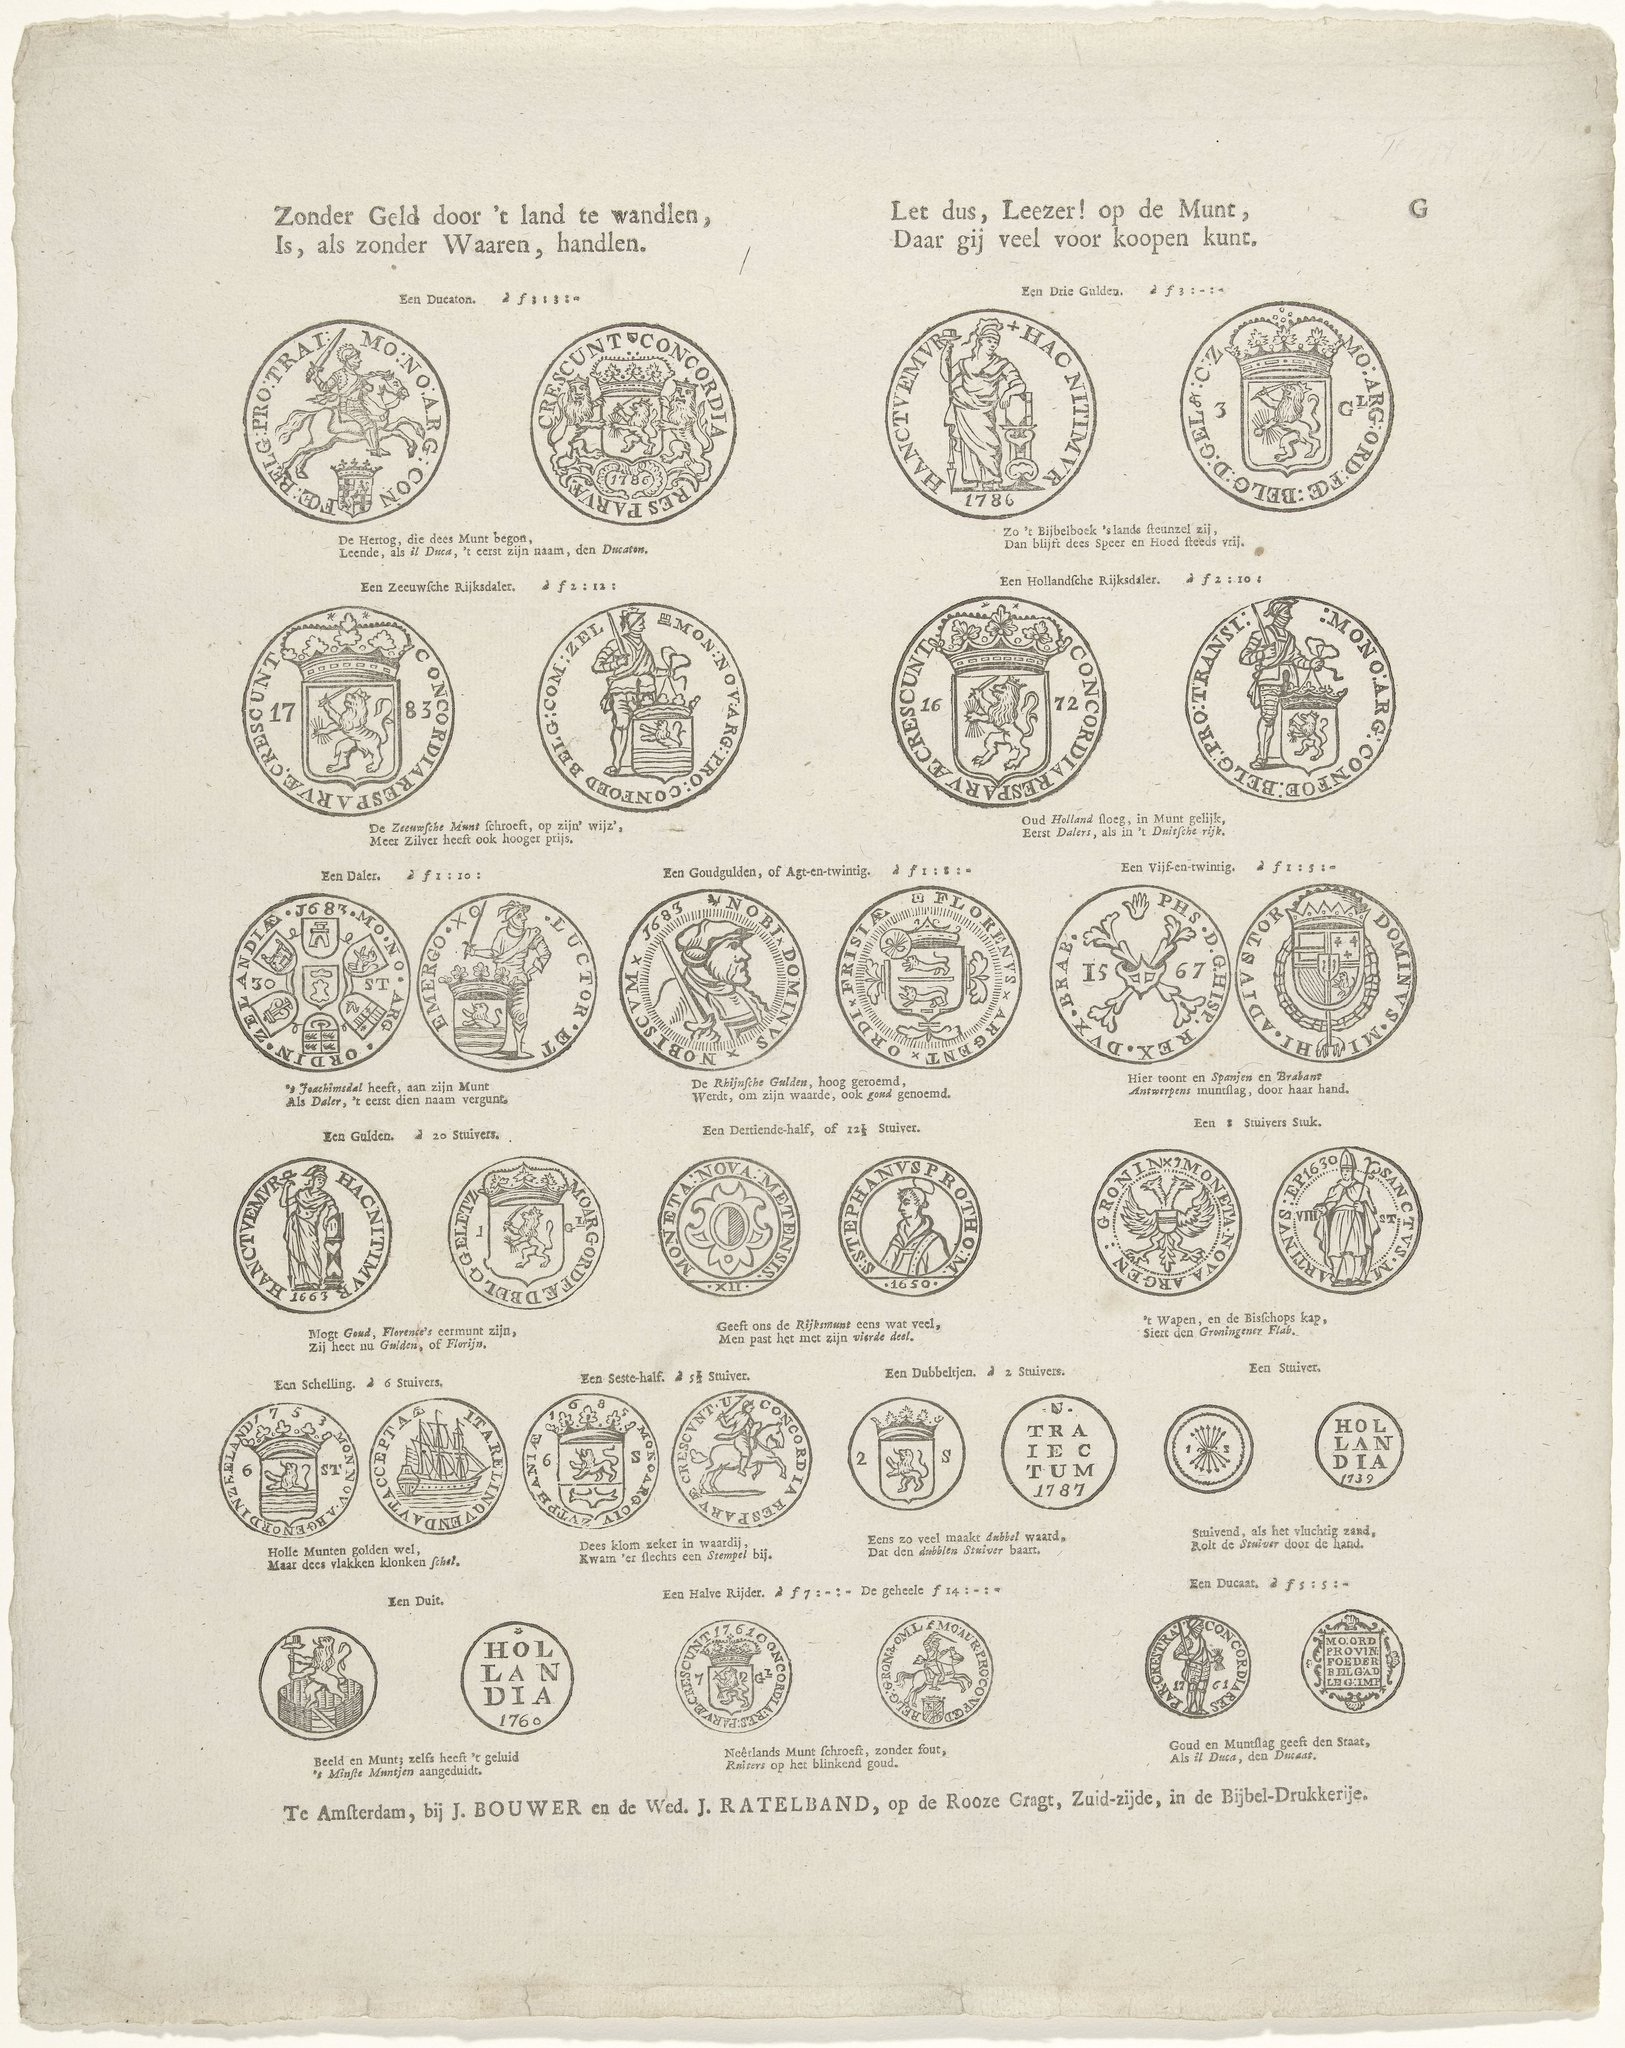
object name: popular print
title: Zonder geld door 't land te wandlen, / Is als zonder waaren, handlen. / Let dus, leezer! op de munt, / Daar gij veel voor koopen kunt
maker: Anonymous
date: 1794-1804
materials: paper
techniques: letterpress printing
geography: netherlands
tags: coin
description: Blad met 17 voorstellingen van oude Nederlandse munten, voor- en keerzijde. Boven elke voorstelling de naam en waarde van de munt, eronder een tweeregelig vers. Genummerd rechtsboven: G.